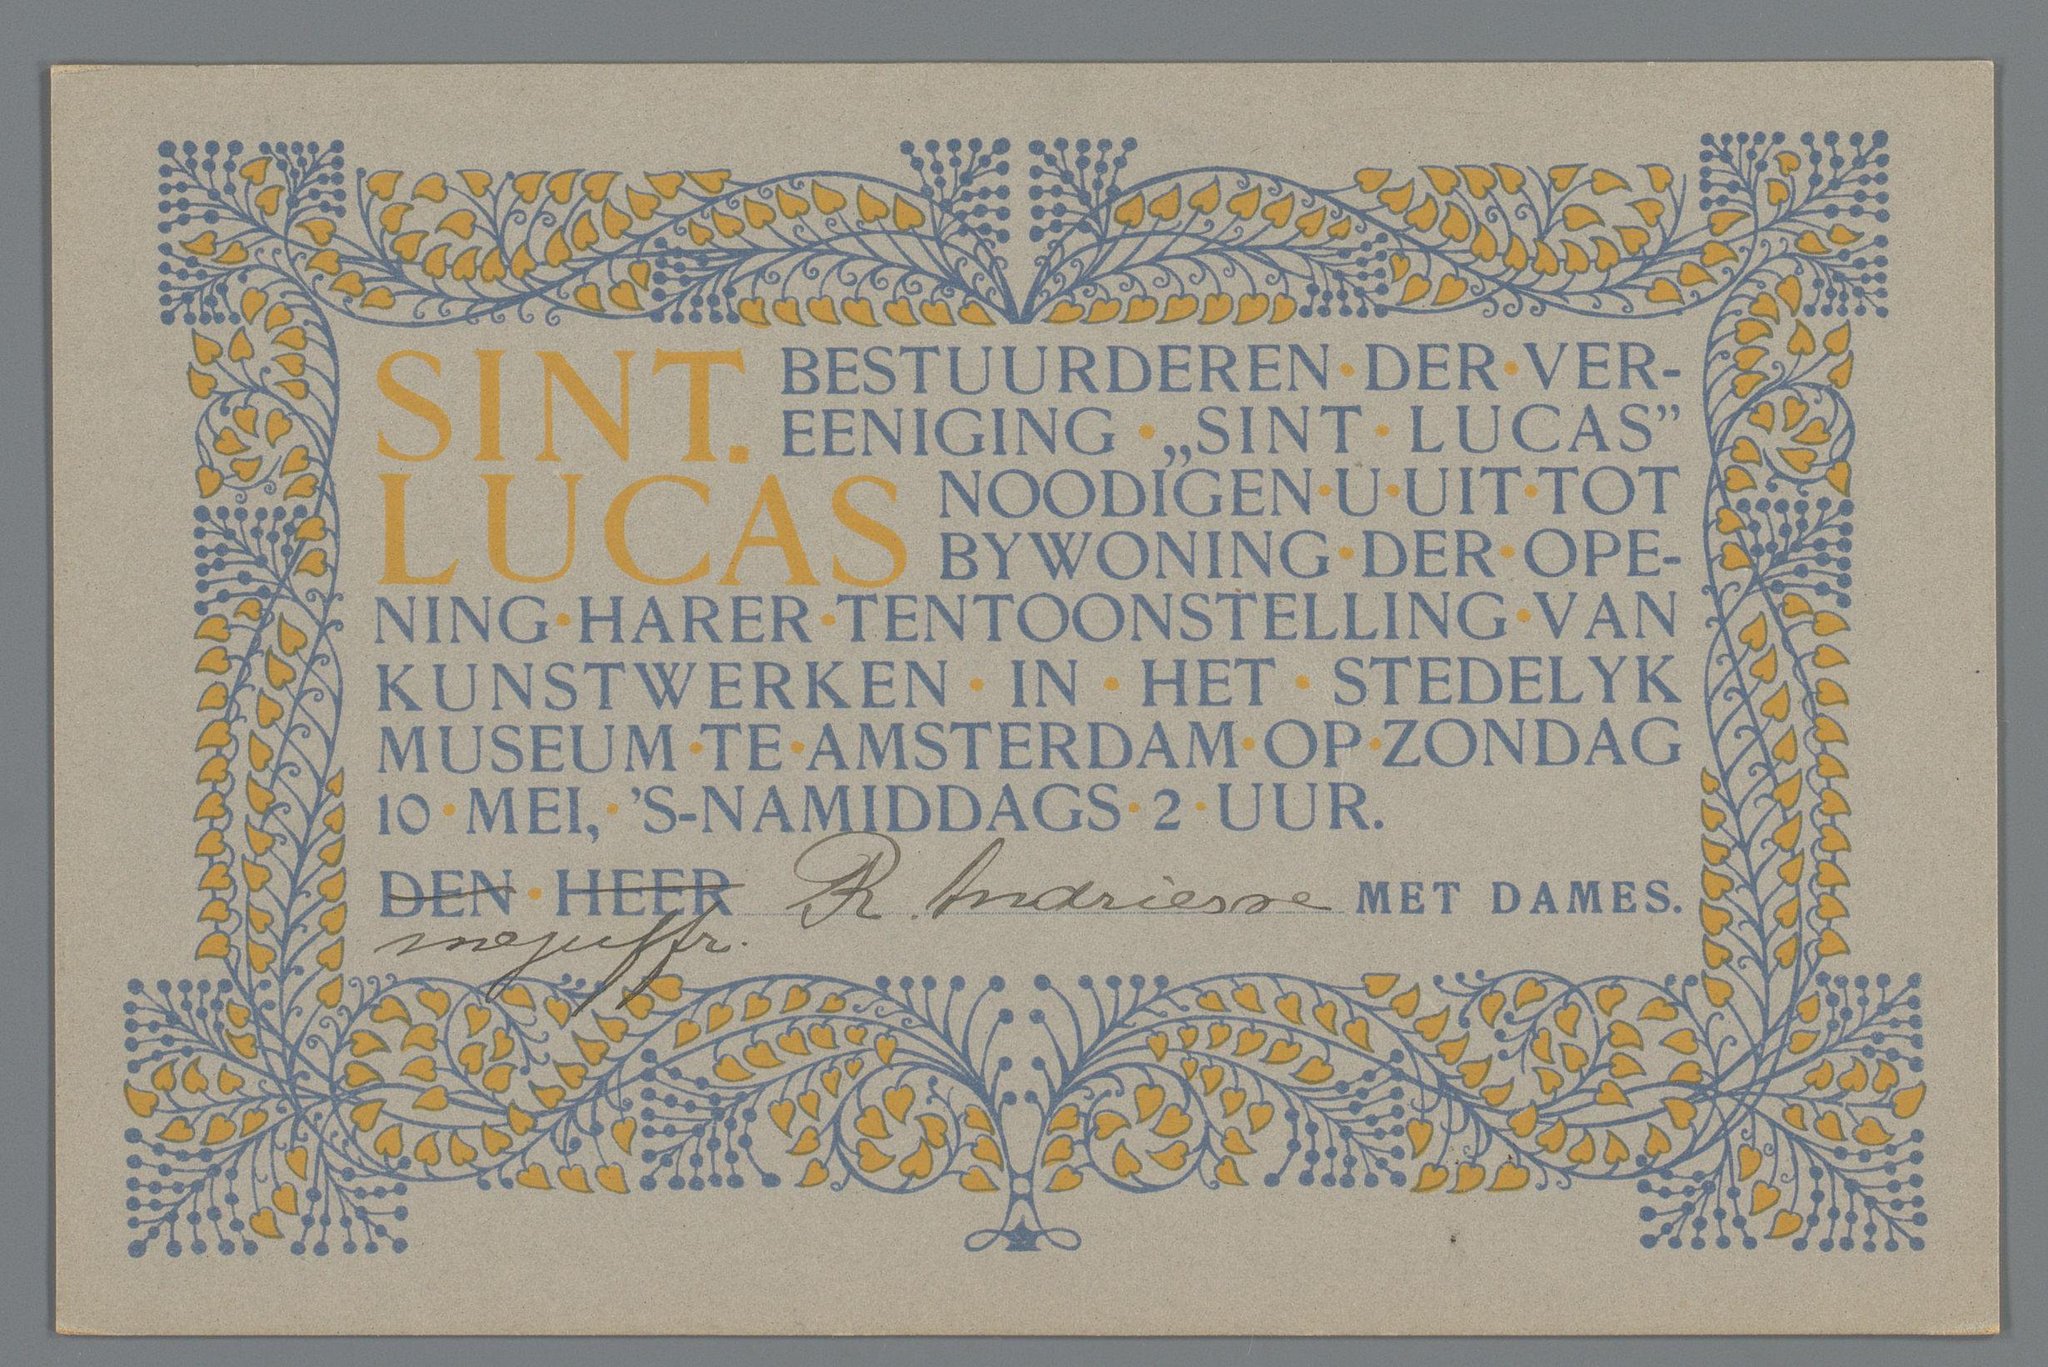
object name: invitation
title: Uitnodiging voor de opening van een tentoonstelling van werken van leden van Kunstenaarsvereniging Sint Lucas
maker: Anonymous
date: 1880-1920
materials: paper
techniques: lithograph, pen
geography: amsterdam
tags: collection, exhibition, show, ornament derived from plant forms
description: Uitnodiging voor tentoonstellingsopening op 10 mei, 14.00 in het Stedelijk Museum Amsterdam. In de ruimte voor adressering is 'Den heer' doorgestreept en vervangen door 'mejuffr.' gevolgd door de naam 'R. Andriessen'.